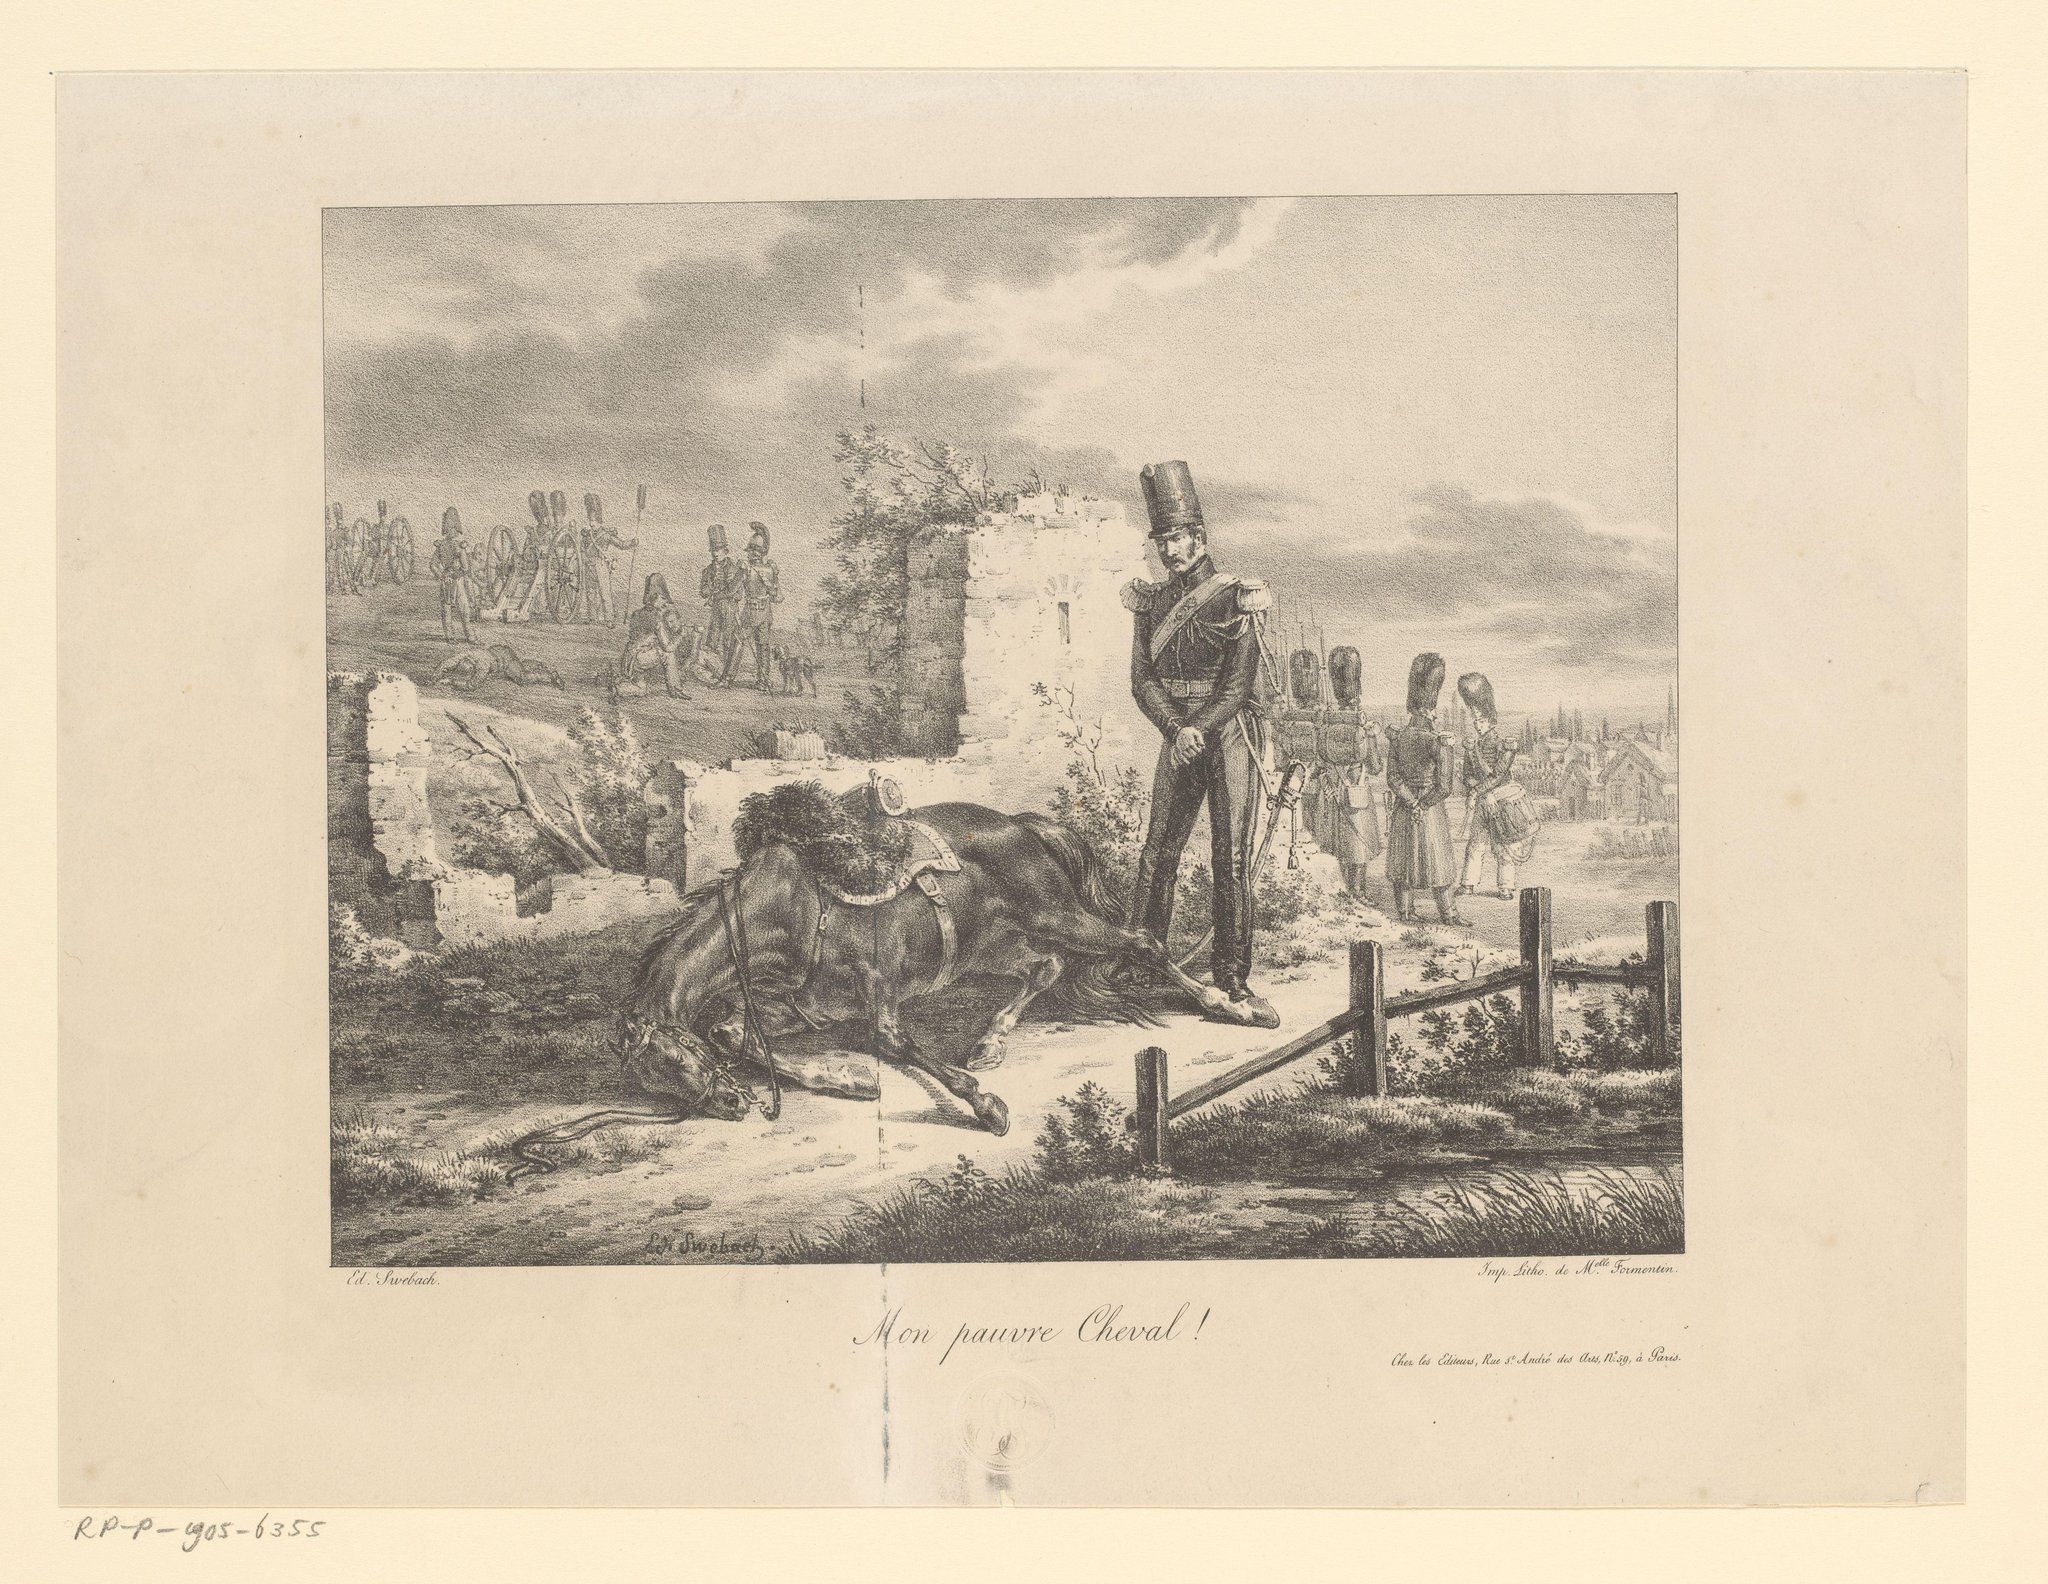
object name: print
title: Militair treurt bij zijn gevallen paard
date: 1822-1856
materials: paper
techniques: lithograph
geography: paris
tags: warfare; military affairs (+ cavalry, horsemen)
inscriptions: collector's mark: Lugt 2228, check stamp: Lugt 3856